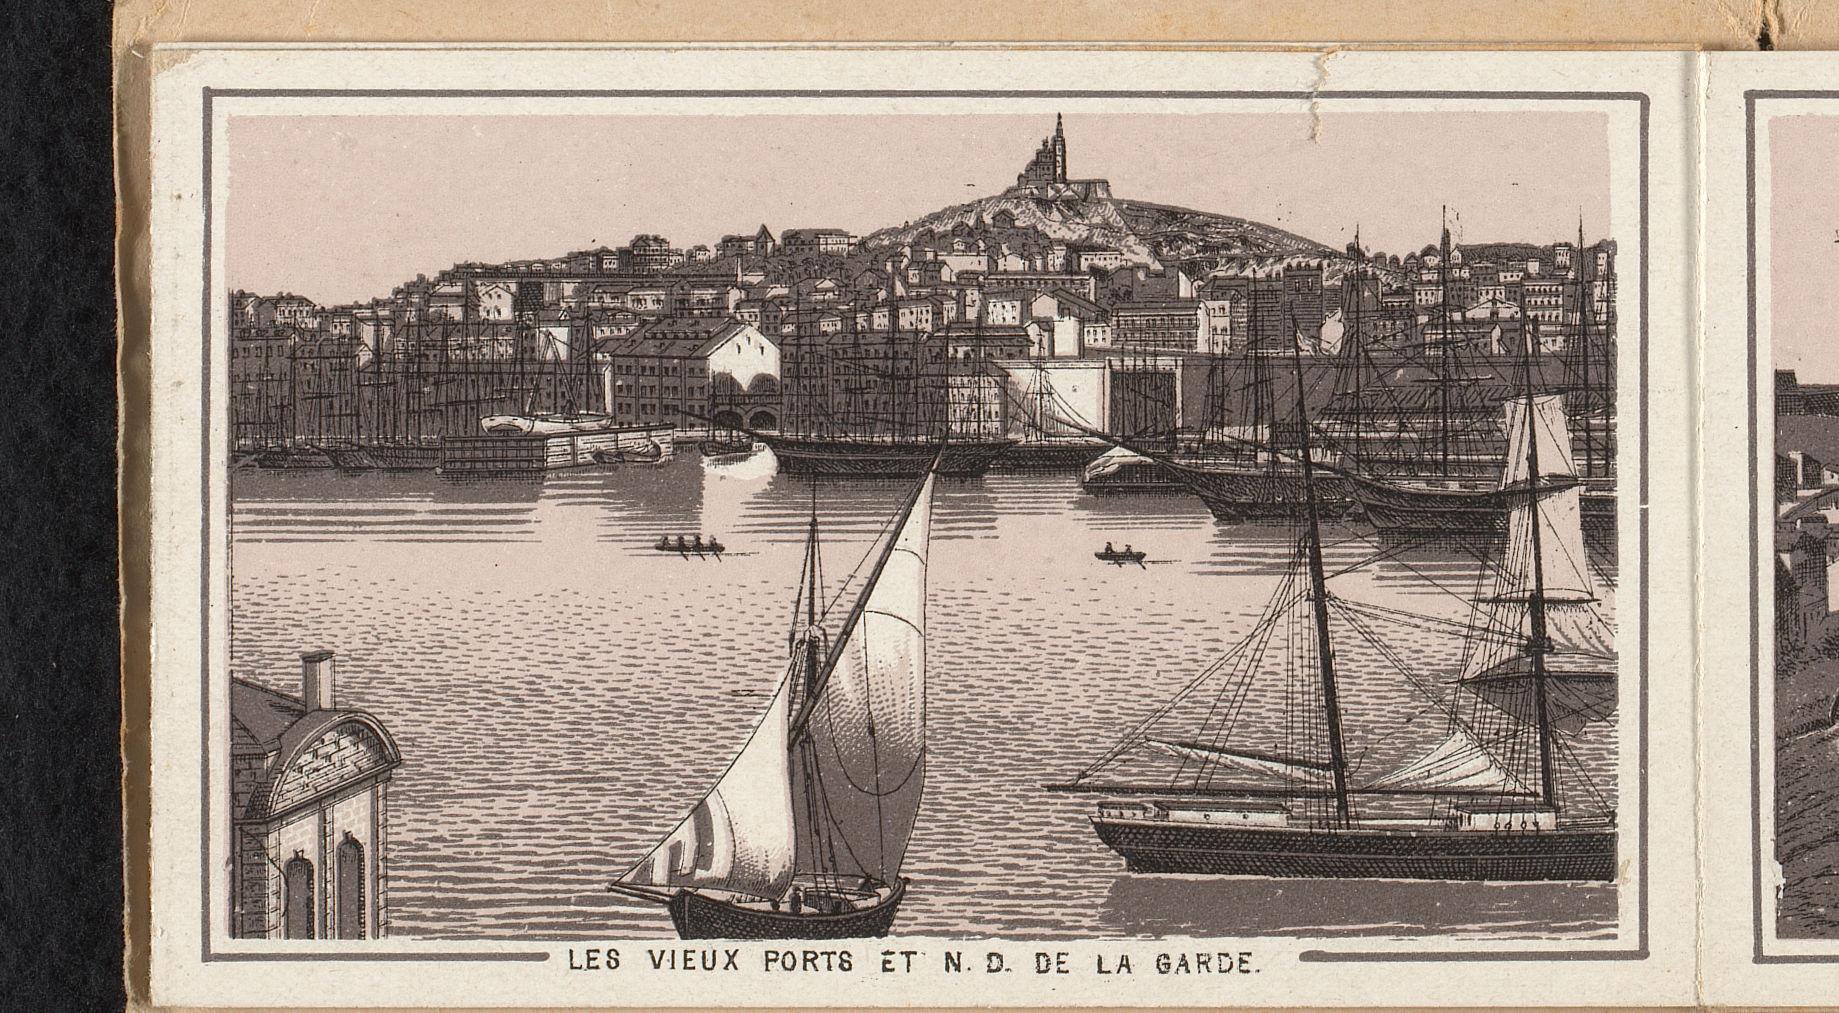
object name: print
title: Les Vieux Ports et N.D. de la Garde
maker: Anonymous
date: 1890-1910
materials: cardboard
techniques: lithograph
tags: harbour, church (exterior), prospect of city, town panorama, silhouette of city